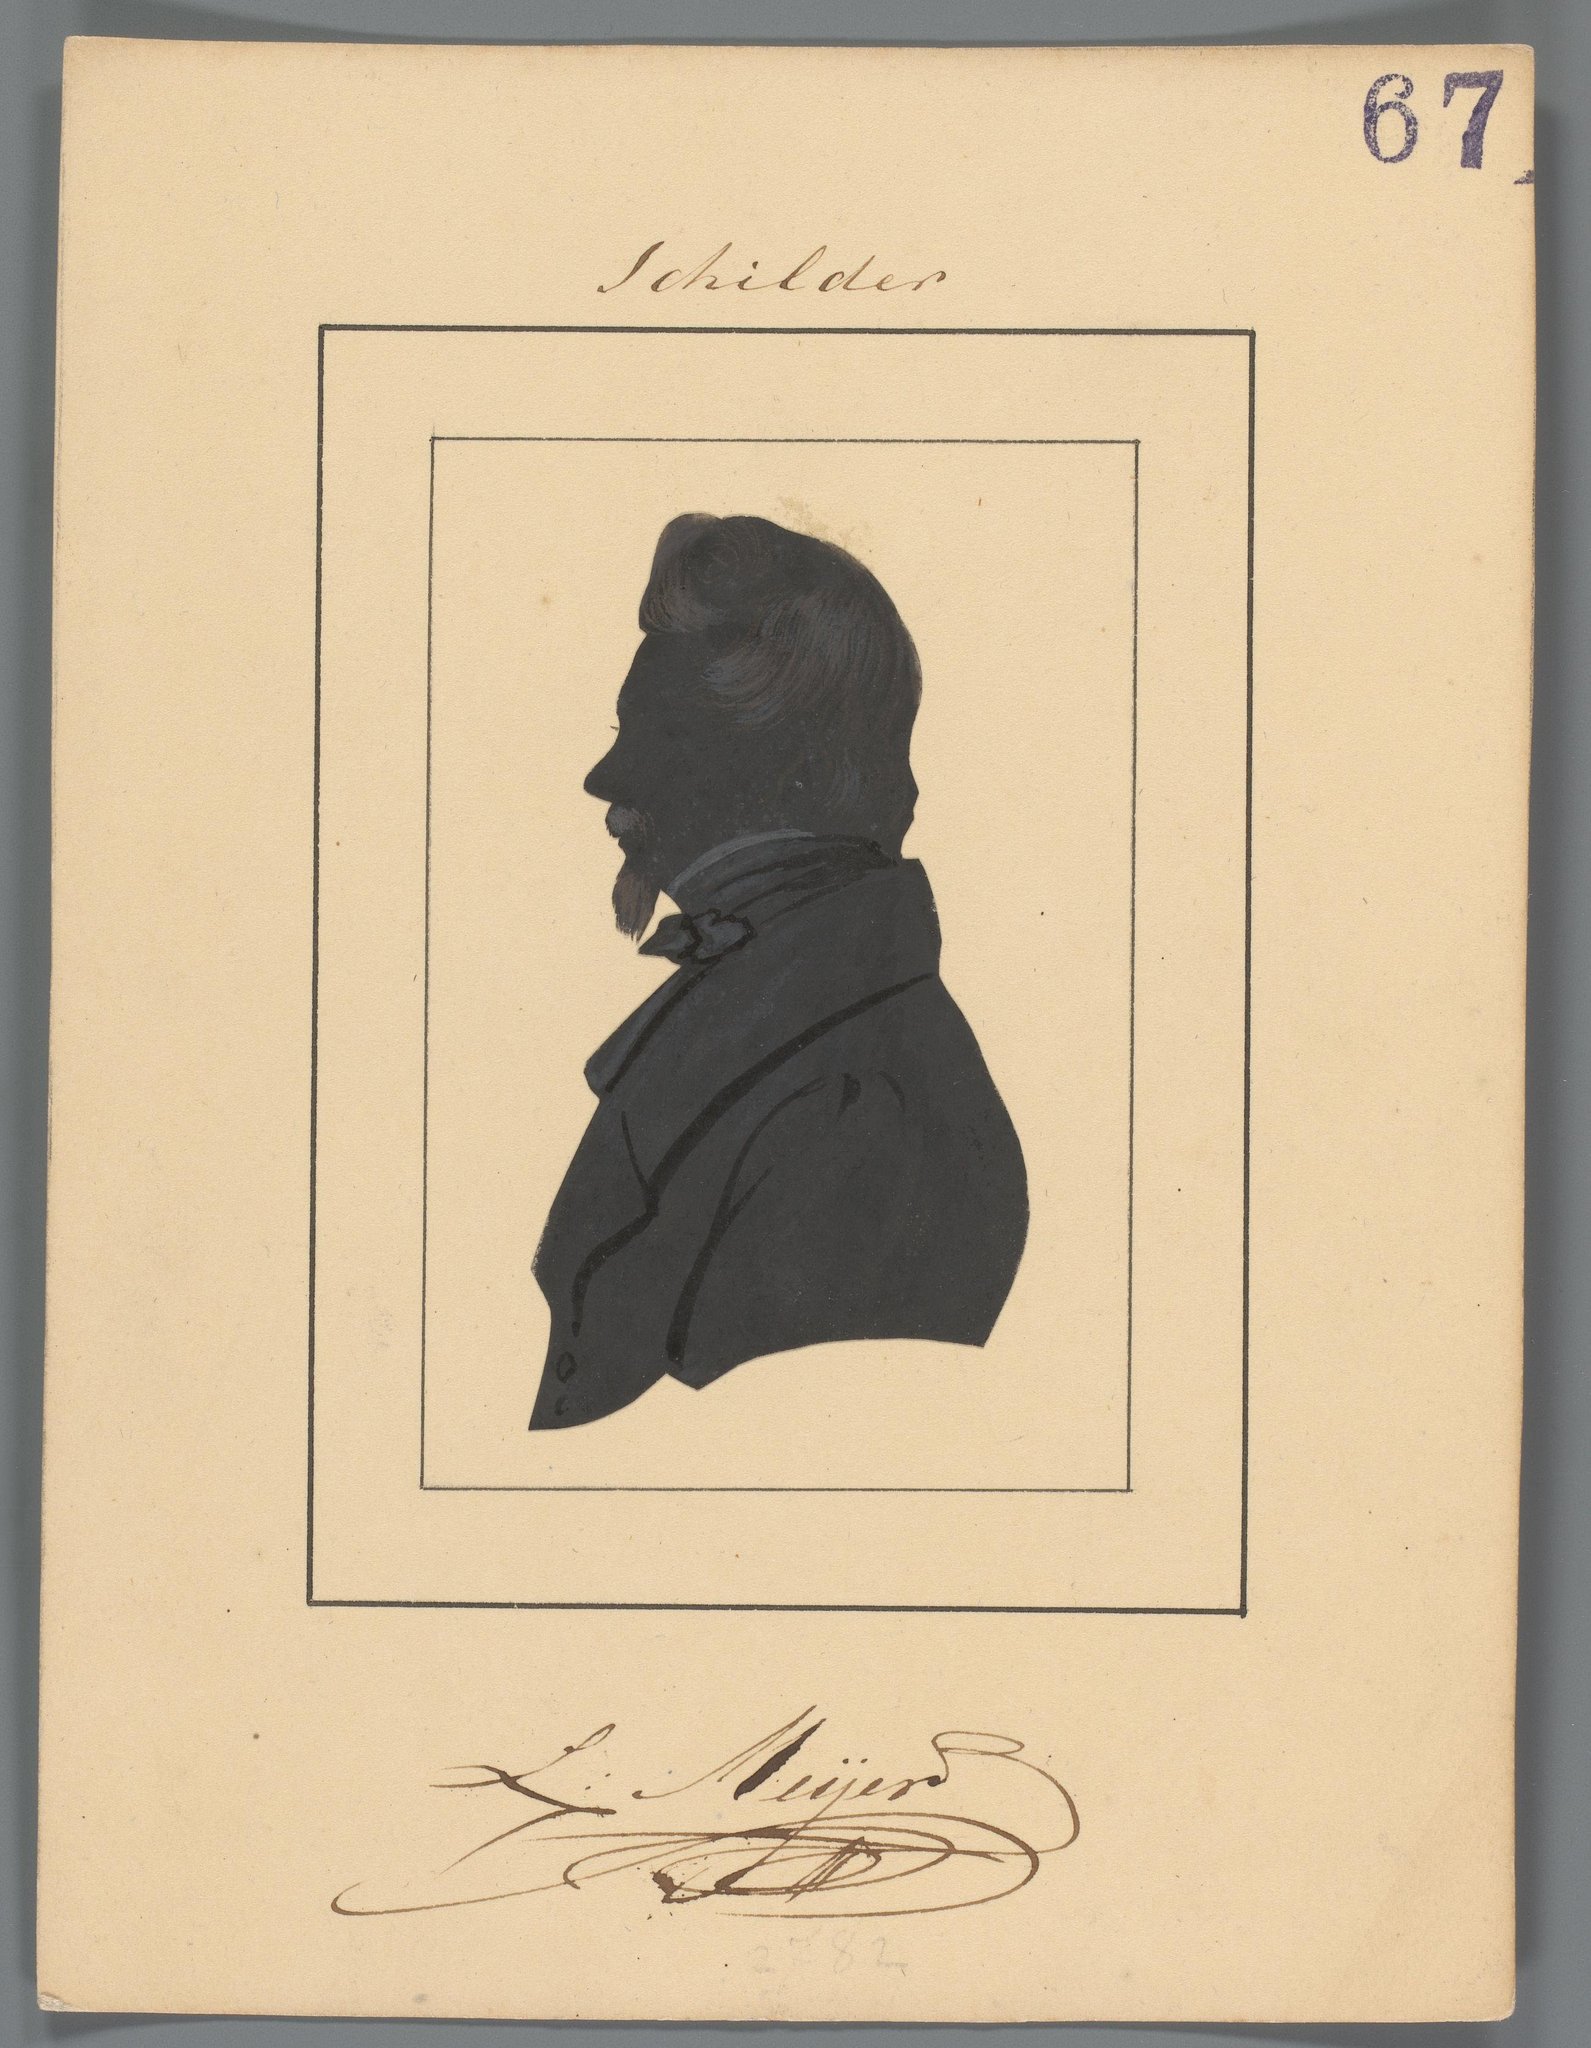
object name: silhouette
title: Silhouetportret van Johan Hendrik Louis Meijer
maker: elisabeth alida haanen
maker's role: draughtsman, print maker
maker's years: 1809-1845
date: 1819-1845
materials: ink, paint, paper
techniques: brush, snipping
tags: louis meijer, historical persons, portrait, self-portrait of painter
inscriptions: number: ‘13991’, collector's mark: ‘Ex-libris van Beresteyn’, inscription: ‘Neg. D. 1784’, inscription: ‘Schilder’, inscription: ‘L: Meijer’, number: ‘67’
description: Met onder het portret de handtekening van de geportretteerde.